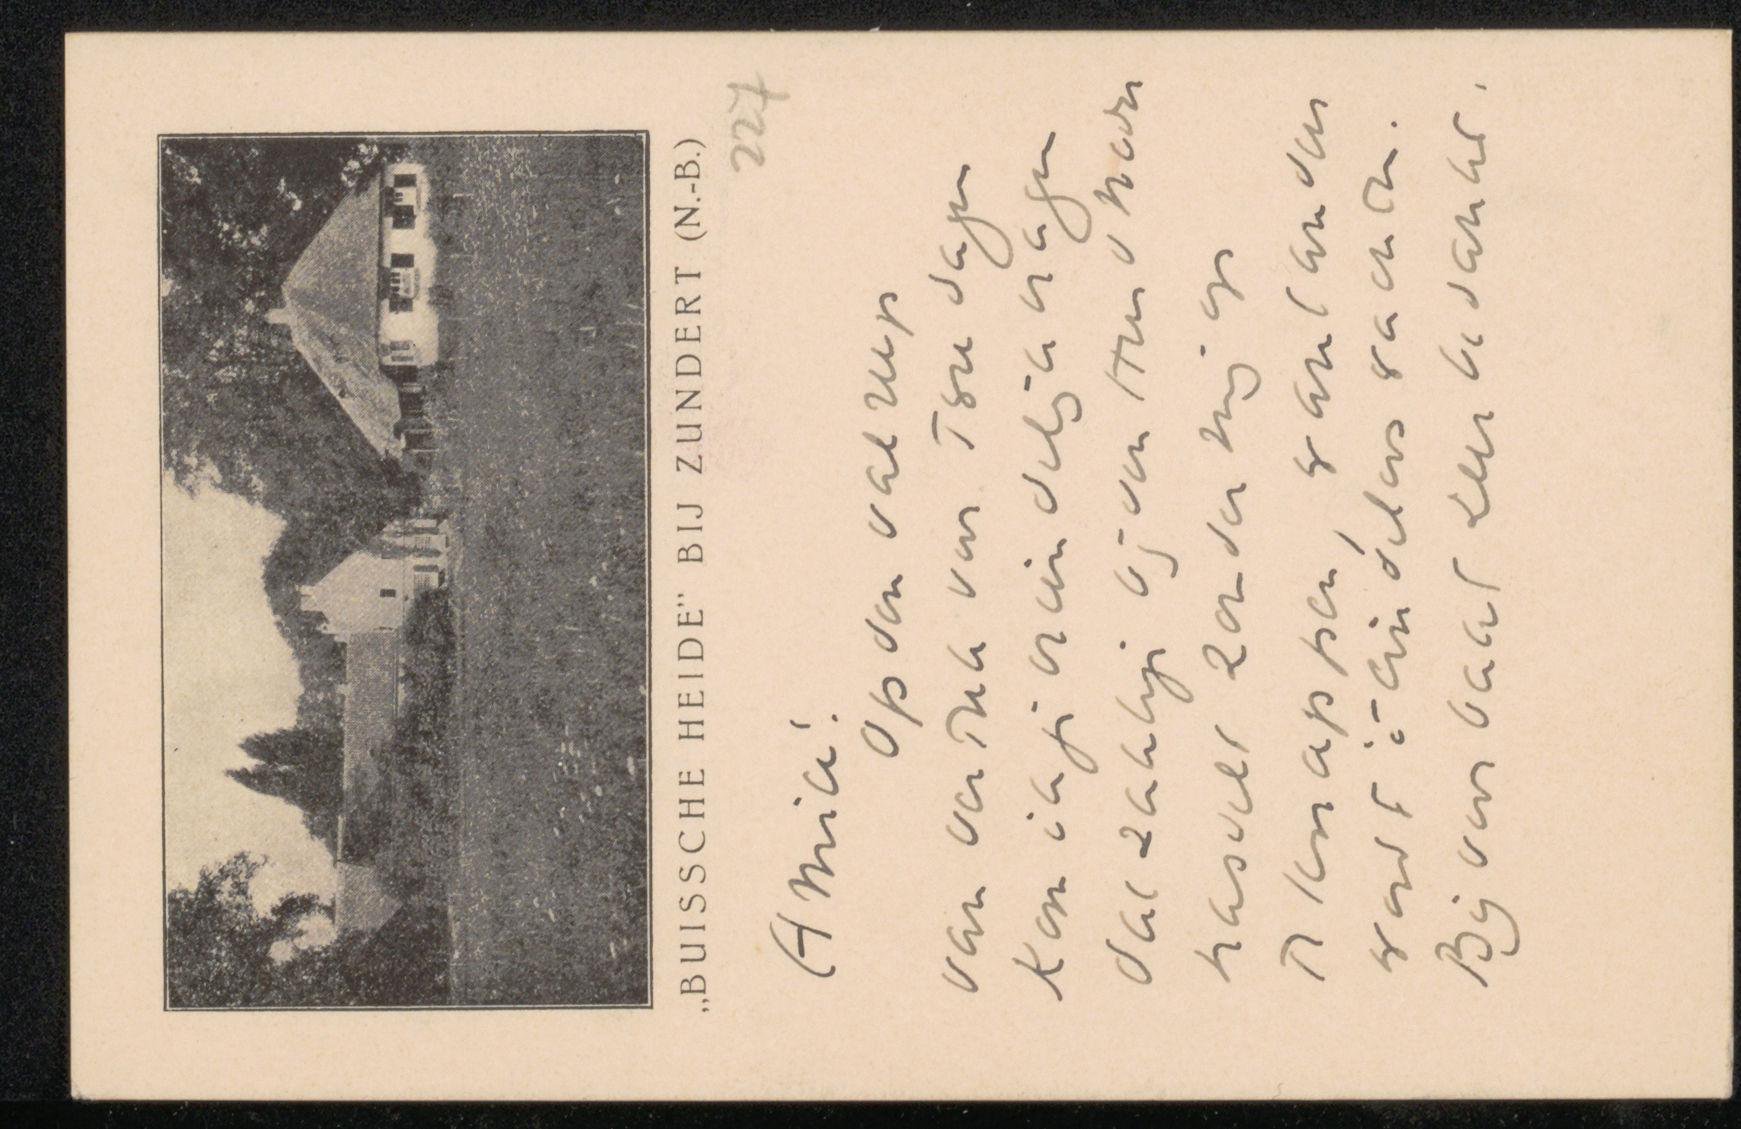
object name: ansichtkaart, prentbriefkaart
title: Prentbriefkaart aan Willem Bogtman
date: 1892-1938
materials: cardboard, ink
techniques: pen, writing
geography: zundert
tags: haarlem, willem bogtman